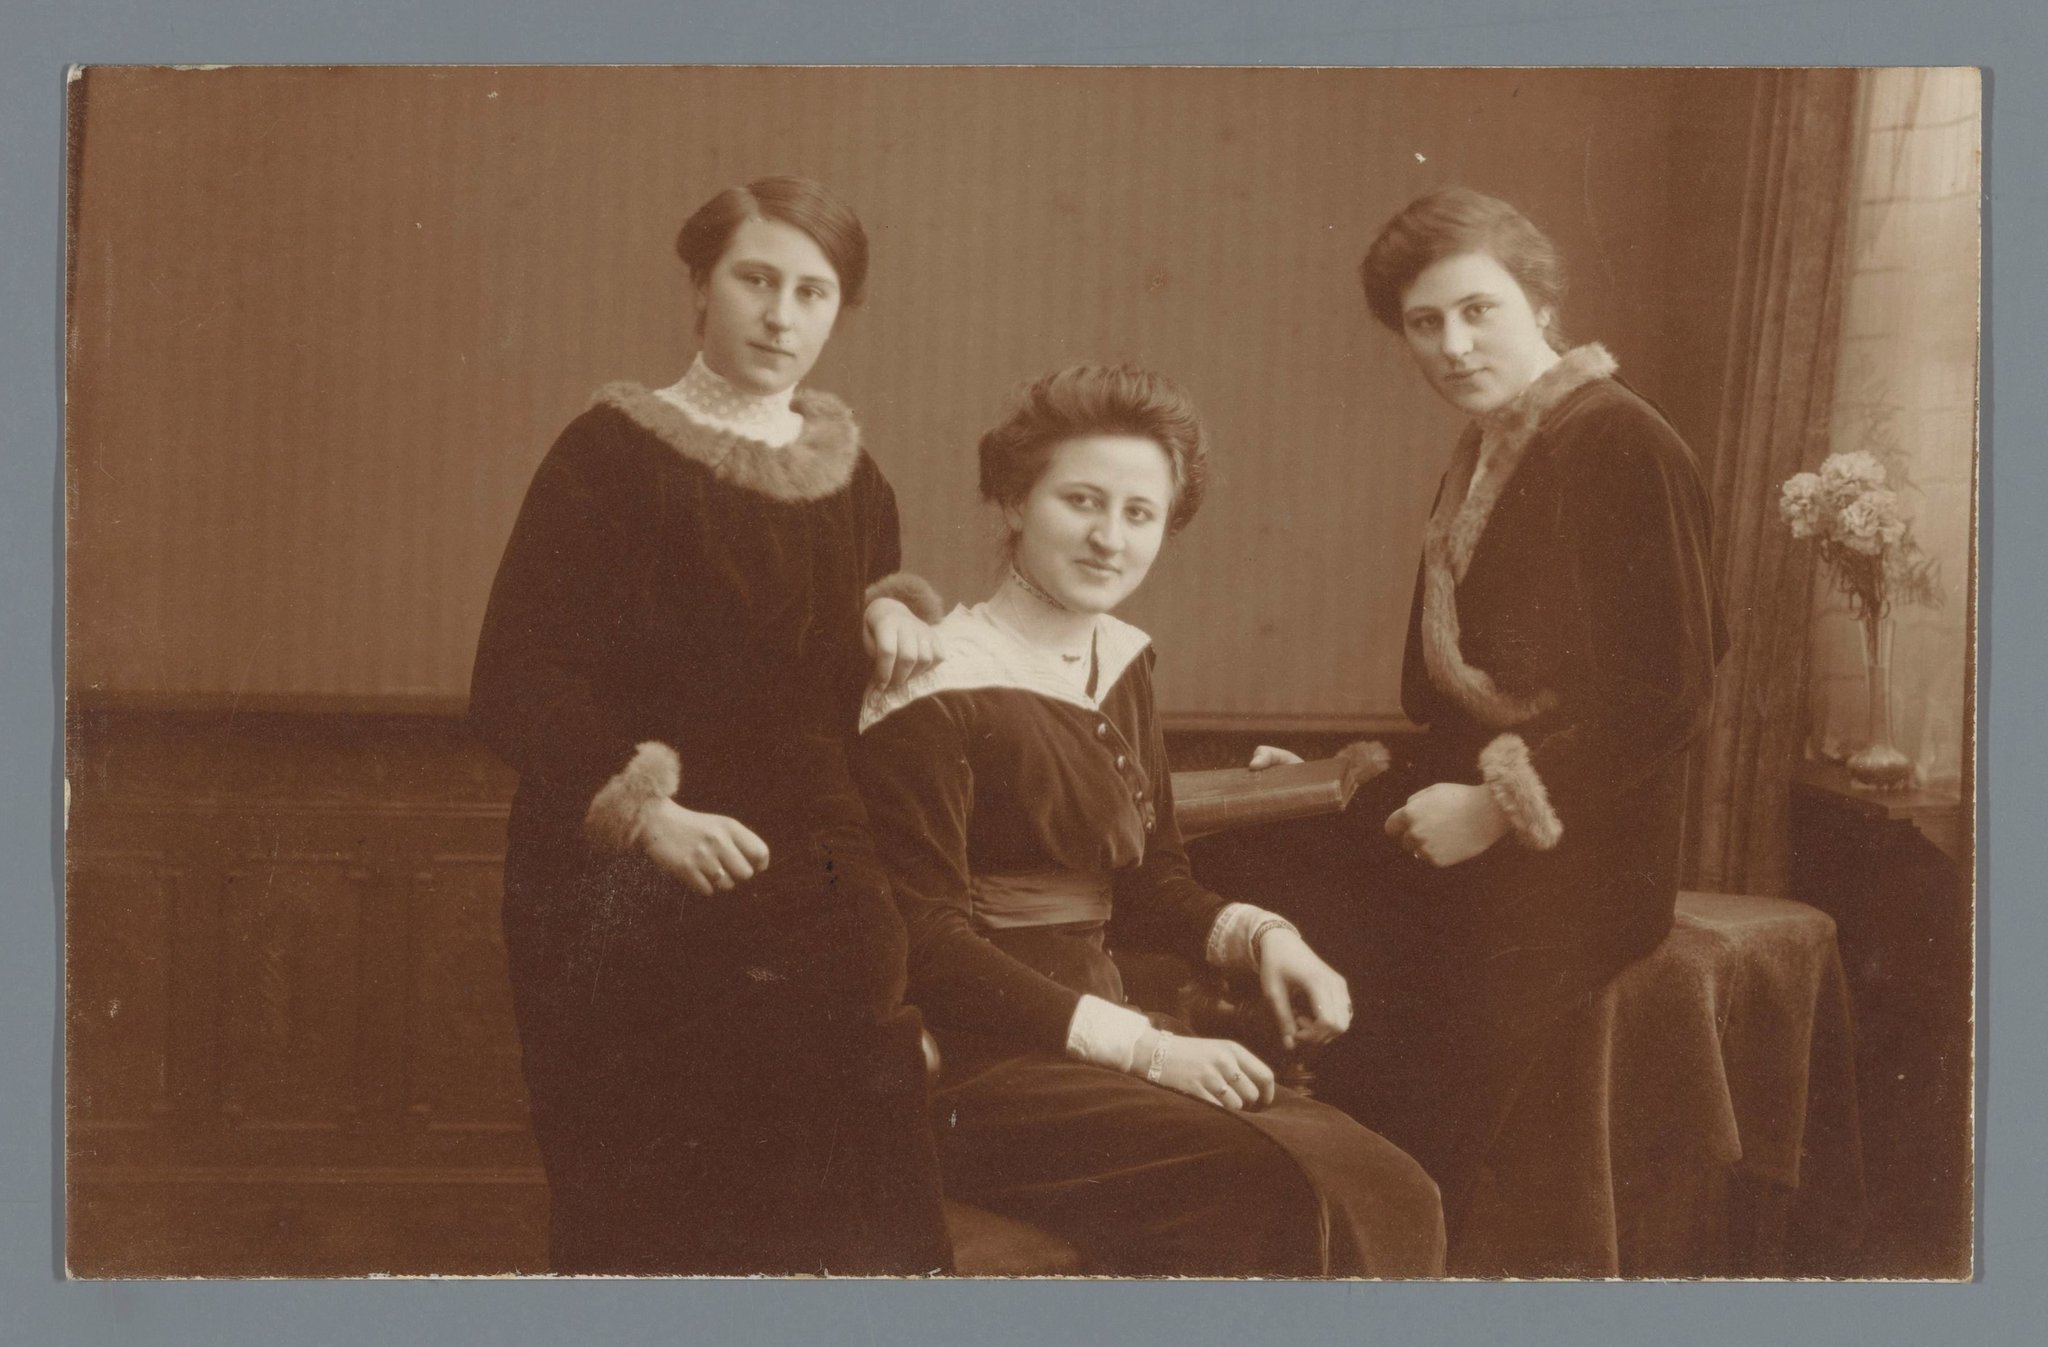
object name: ansichtkaart, prentbriefkaart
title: Studioportret van drie onbekende vrouwen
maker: pier steensma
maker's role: fotograaf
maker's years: 1879-1931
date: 1907-1920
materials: photographic support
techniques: gelatin silver print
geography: amsterdam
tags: adult woman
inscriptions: inscription: ‘P. Steensma Amsterdam Heerenstraat 6’